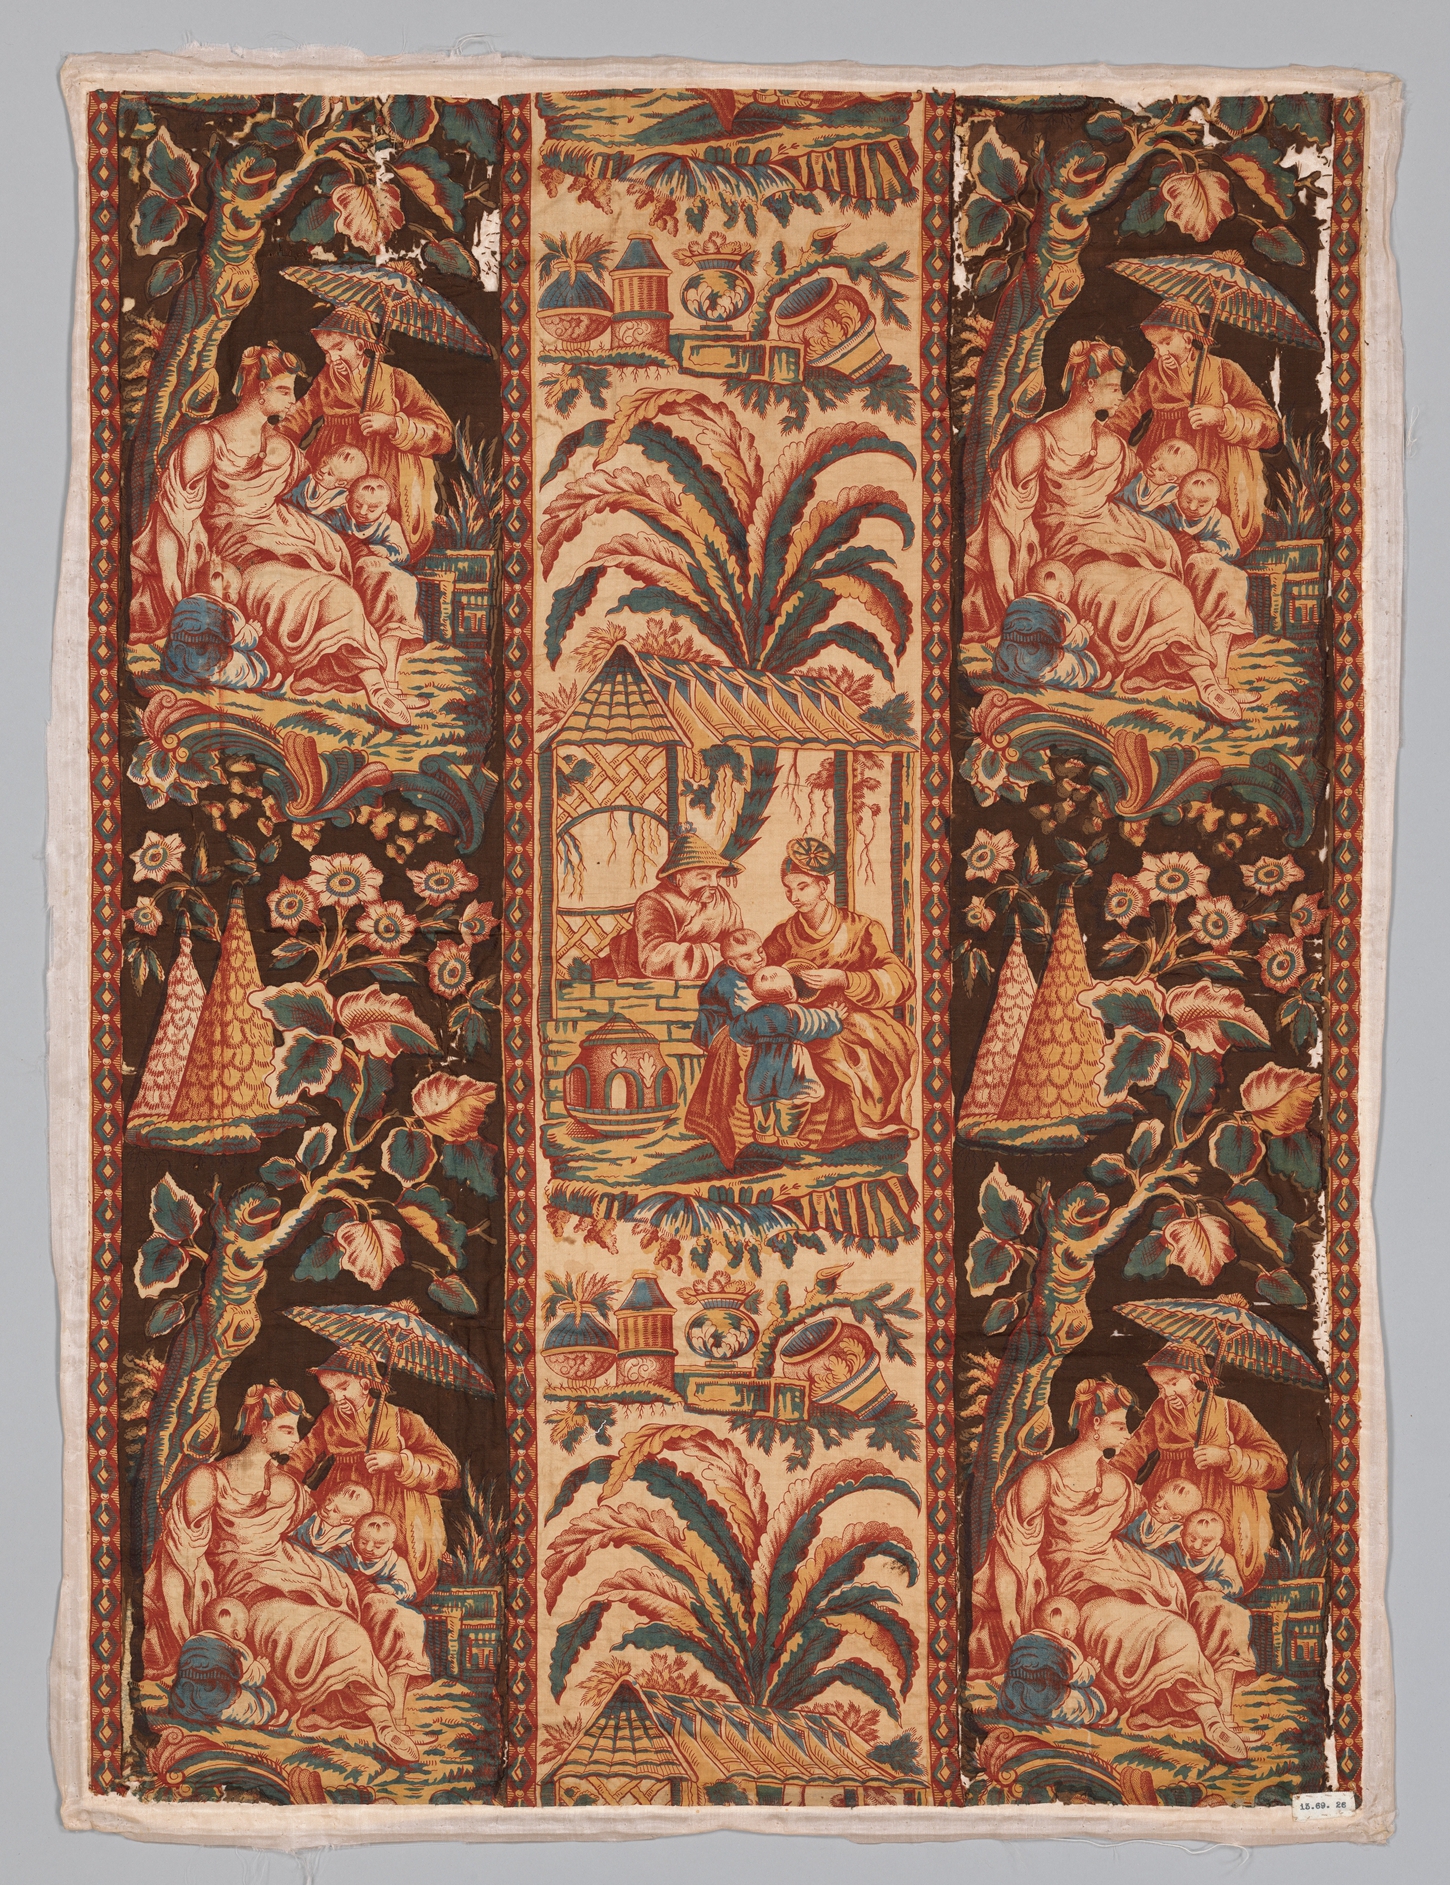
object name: piece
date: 1825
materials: cotton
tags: men,flowers,leaves,trees